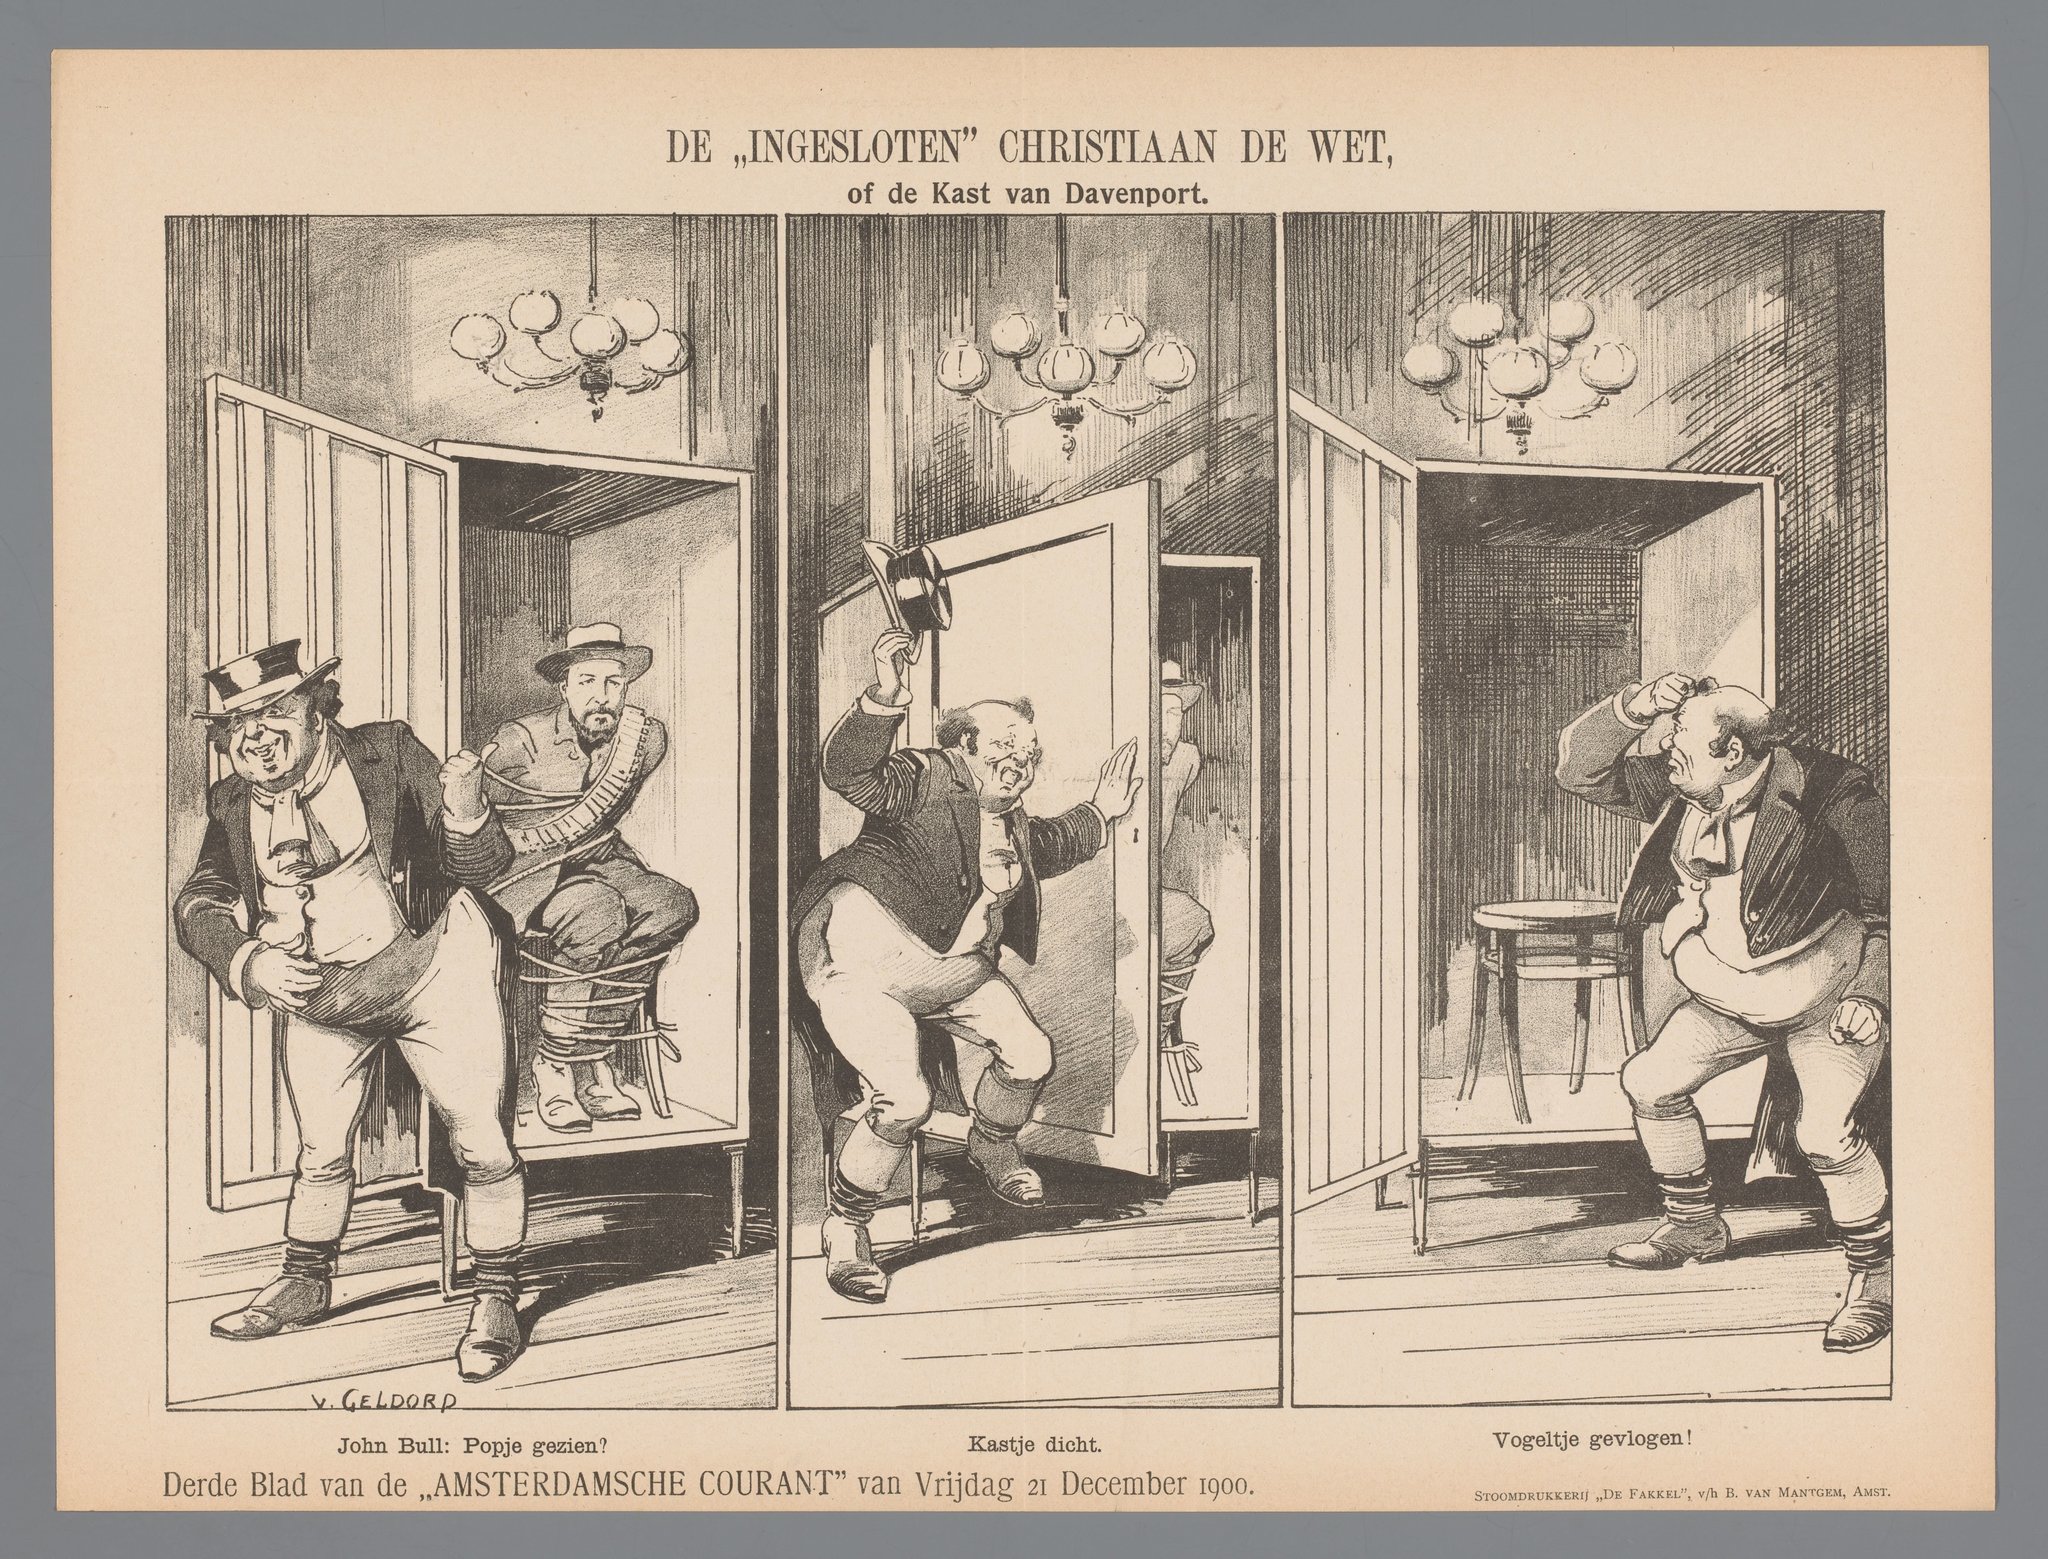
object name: cartoon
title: De "ingesloten" Christiaan de Wet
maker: petrus van geldorp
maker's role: draughtsman, print maker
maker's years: 1872-1939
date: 1900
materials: paper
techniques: lithograph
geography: amsterdam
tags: politician, personifications of countries, nations, states, districts, etc., historical persons, political caricatures and satires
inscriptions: date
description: Prent uit het bijvoegsel van: De Amsterdamsche Courant, 21 december 1900.